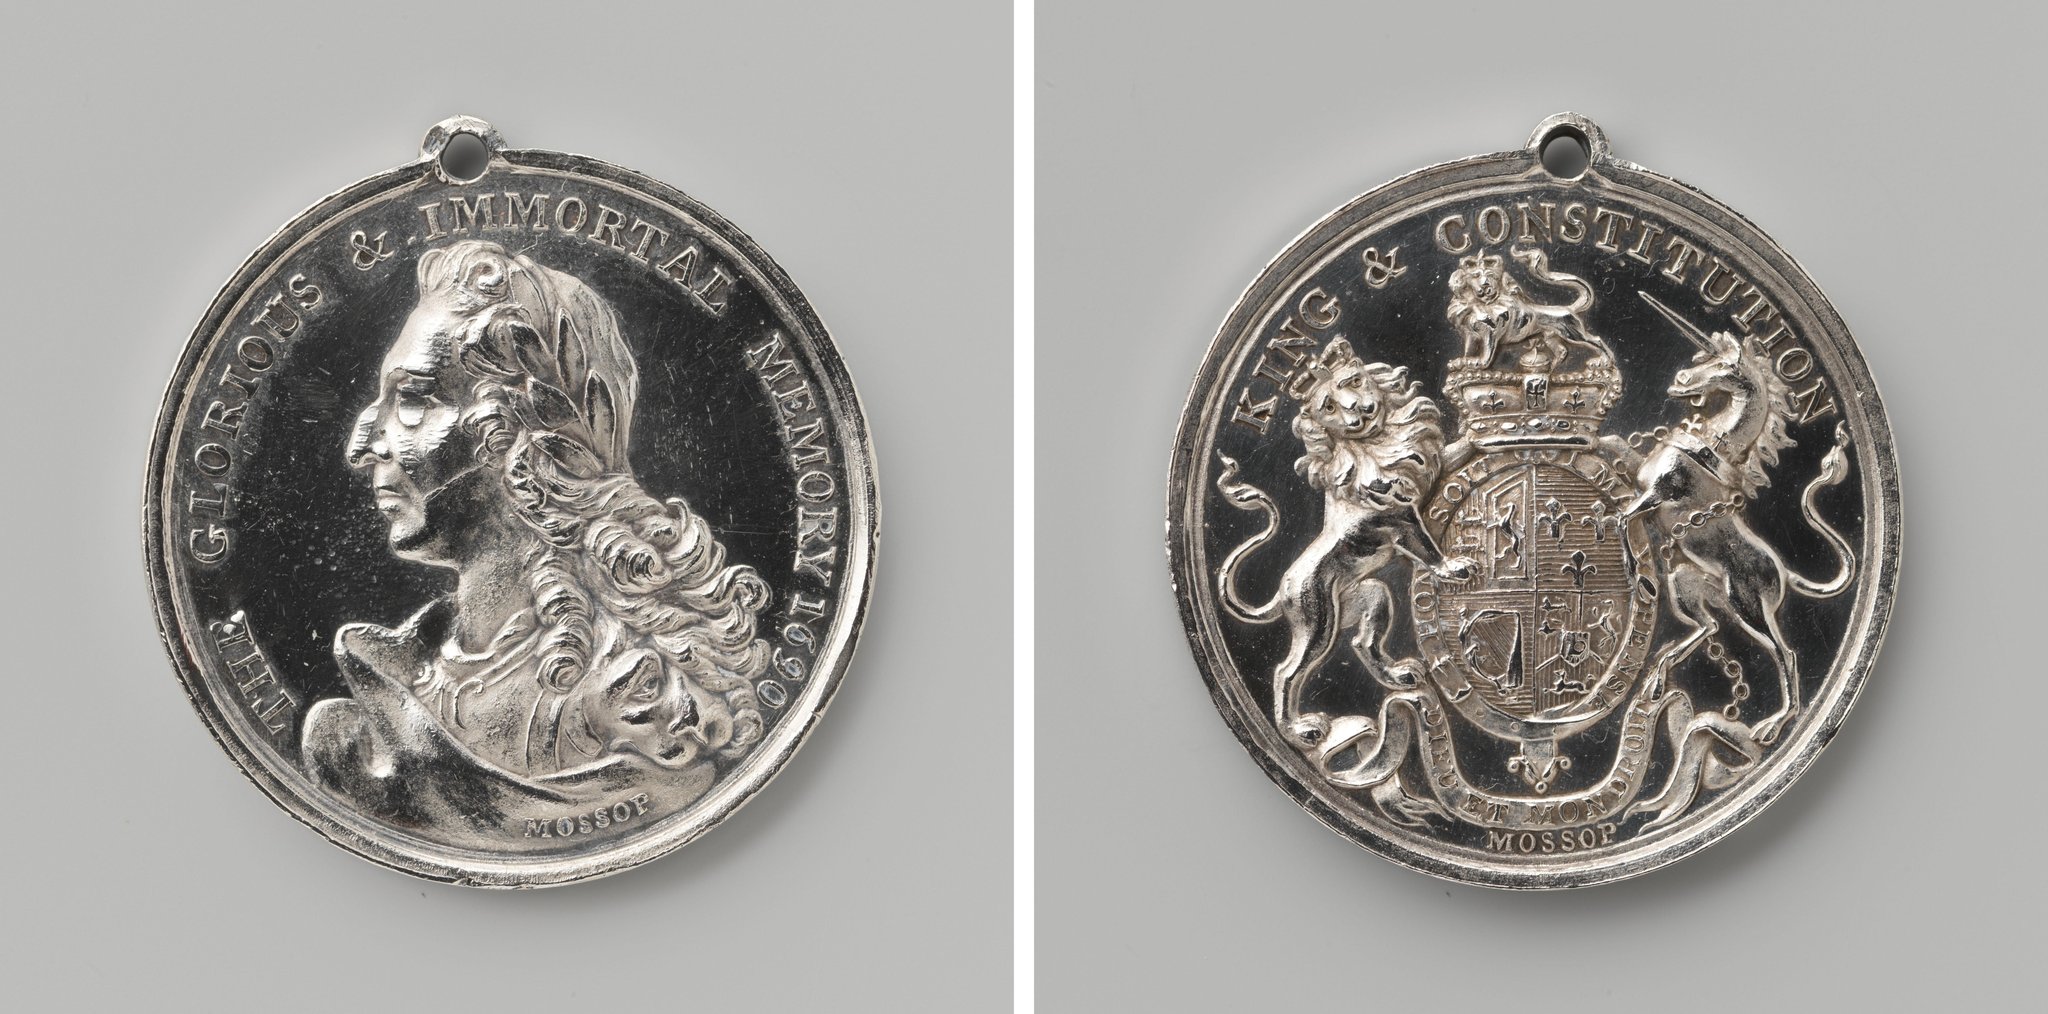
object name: history medal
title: Willem III, prins van Oranje-Nassau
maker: william stephen mossop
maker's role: medailleur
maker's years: 1788-1827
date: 1806-1827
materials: silver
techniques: striking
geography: dublin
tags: the hague, william iii (prince of orange and king of england, scotland, and ireland)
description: Zilveren penning. Voorzijde: borststuk man met lauwerkrans binnen omschrift. Keerzijde: gekroond wapenschild geflankeerd door gekroonde leeuw en eenhoorn binnen omschrift